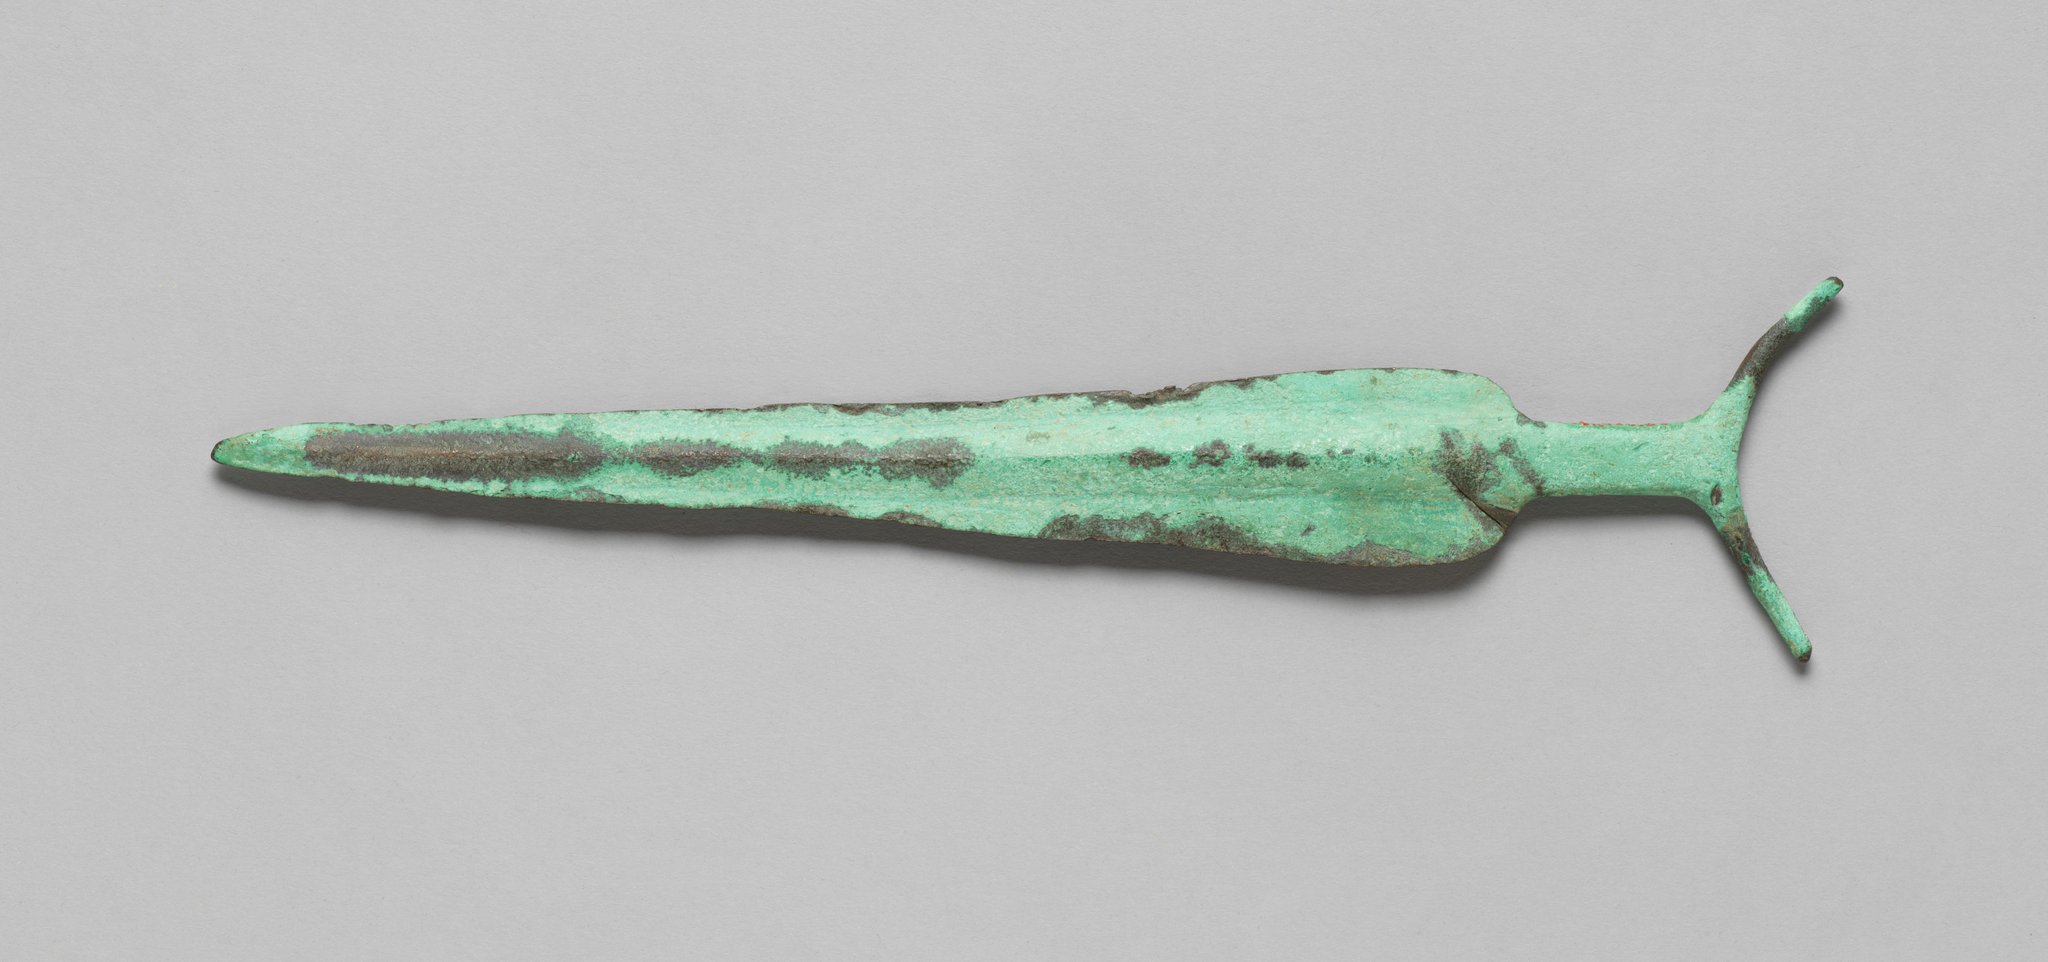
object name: antenna sword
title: Antennae Sword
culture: indian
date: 1500-500 BCE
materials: copper